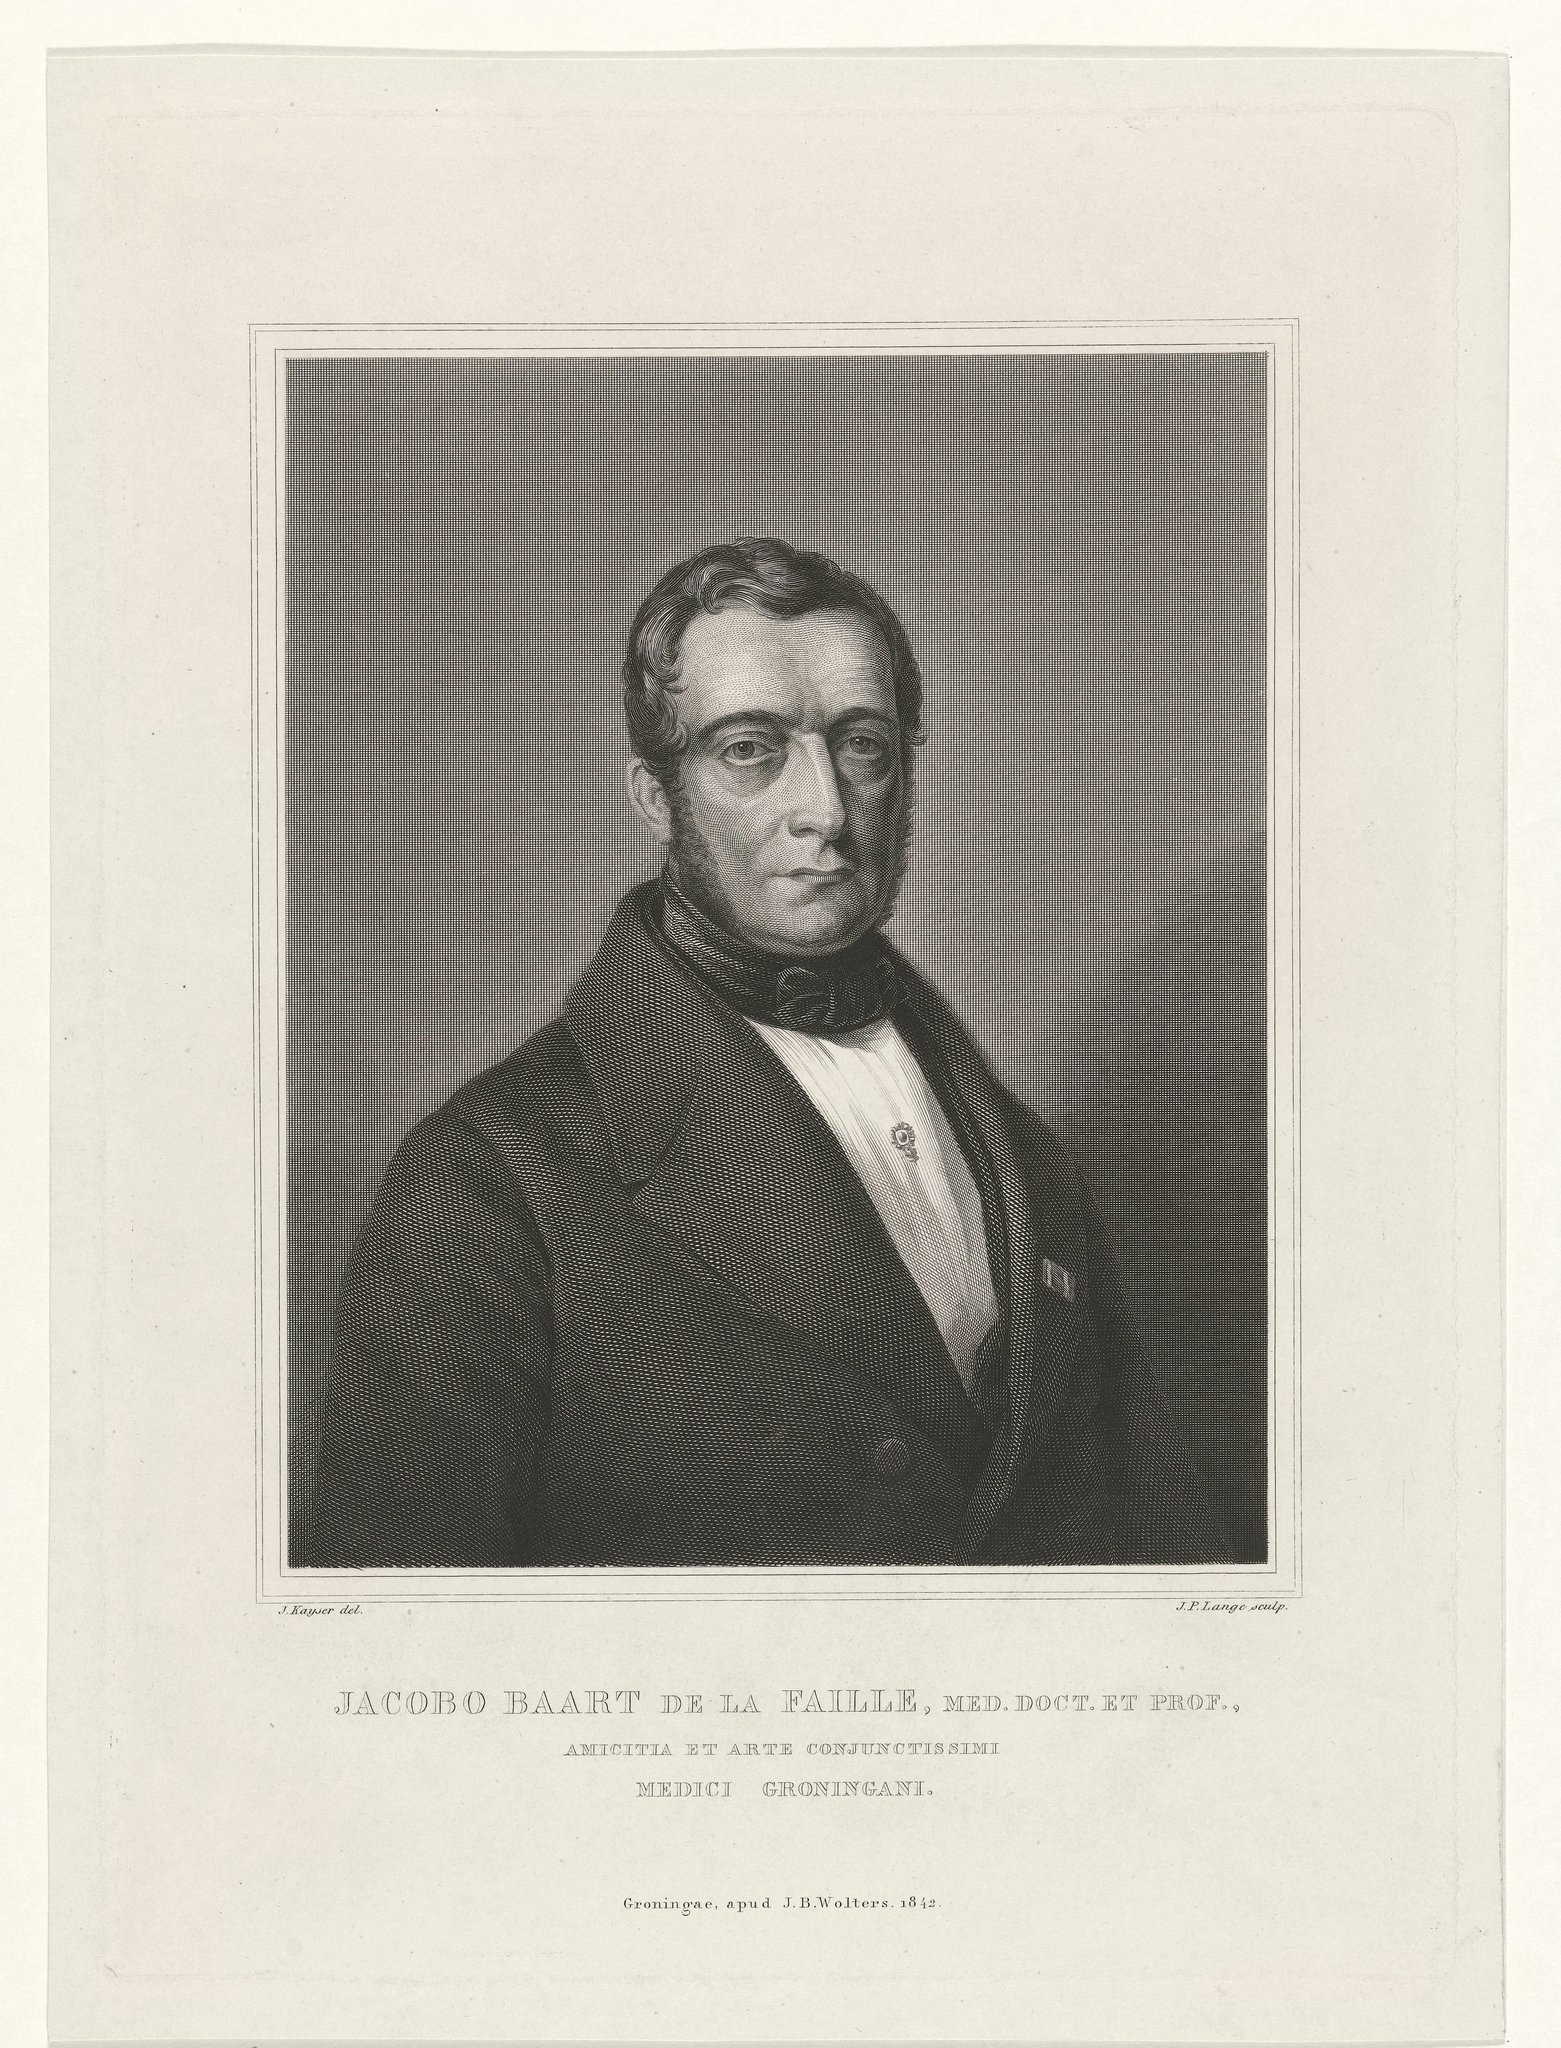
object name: print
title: Jacobo Baart de la Faille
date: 1842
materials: paper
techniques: engraving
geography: groningen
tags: hoogleraar, geneeskundige, arts, jacob ii baart de la faille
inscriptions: collector's mark: Lugt 2228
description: Portretbuste naar rechts van Jacobus Baart de la Faille, hoogleraar in de geneeskunde te Groningen, blootshoofds. In de marge staat een onderschrift in Latijn.